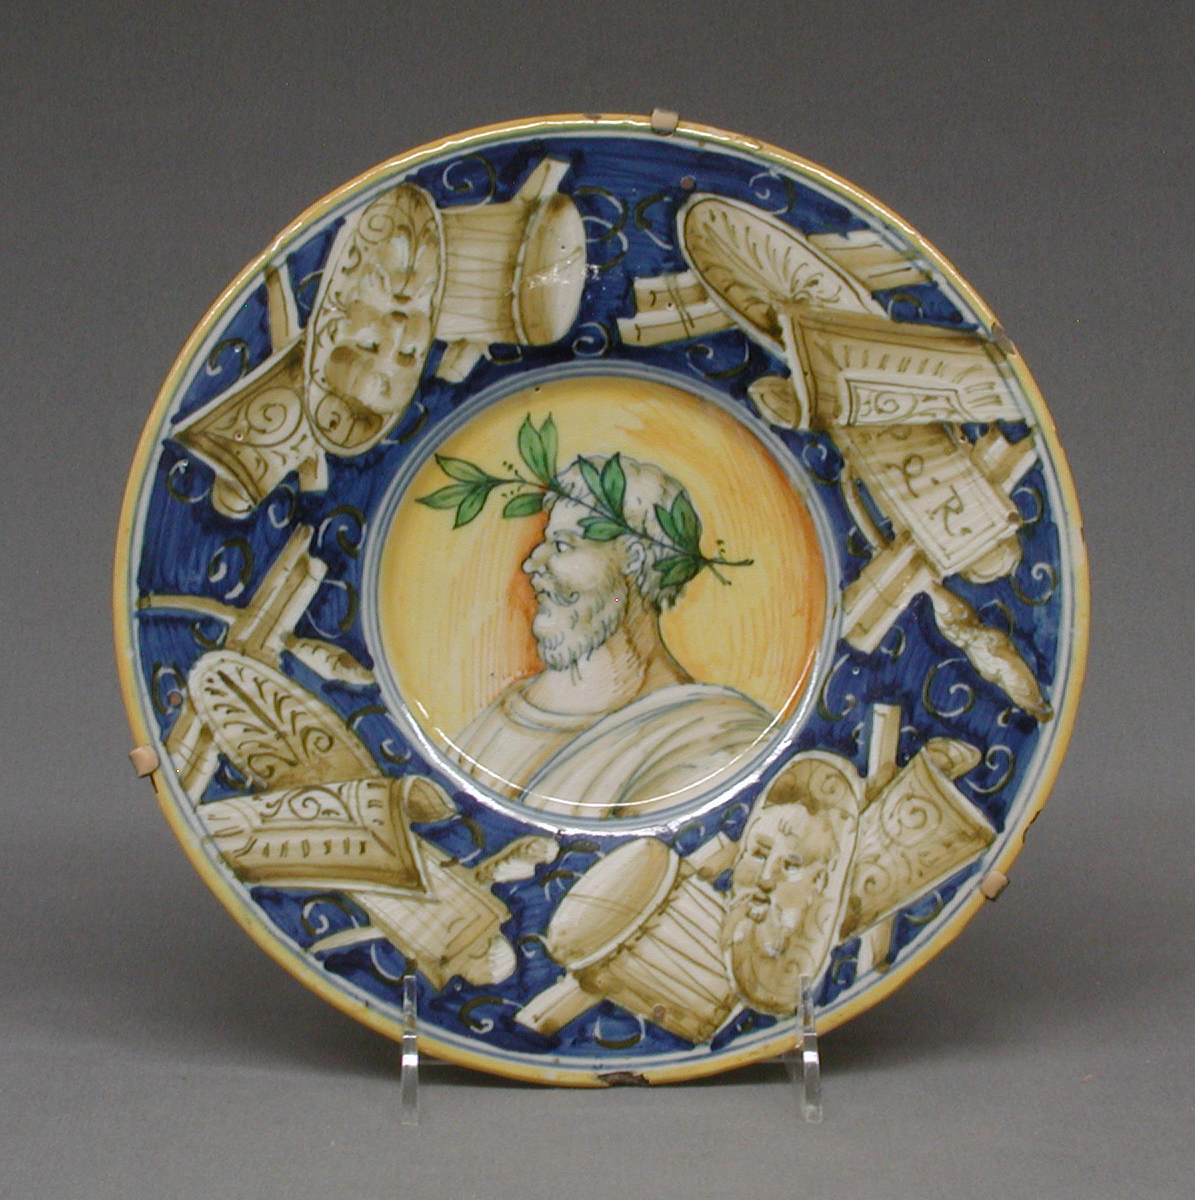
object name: dish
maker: eleucadio solombrino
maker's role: decorator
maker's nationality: italian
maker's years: 1500-1600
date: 1560-1565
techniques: maiolica, glazing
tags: men,profiles